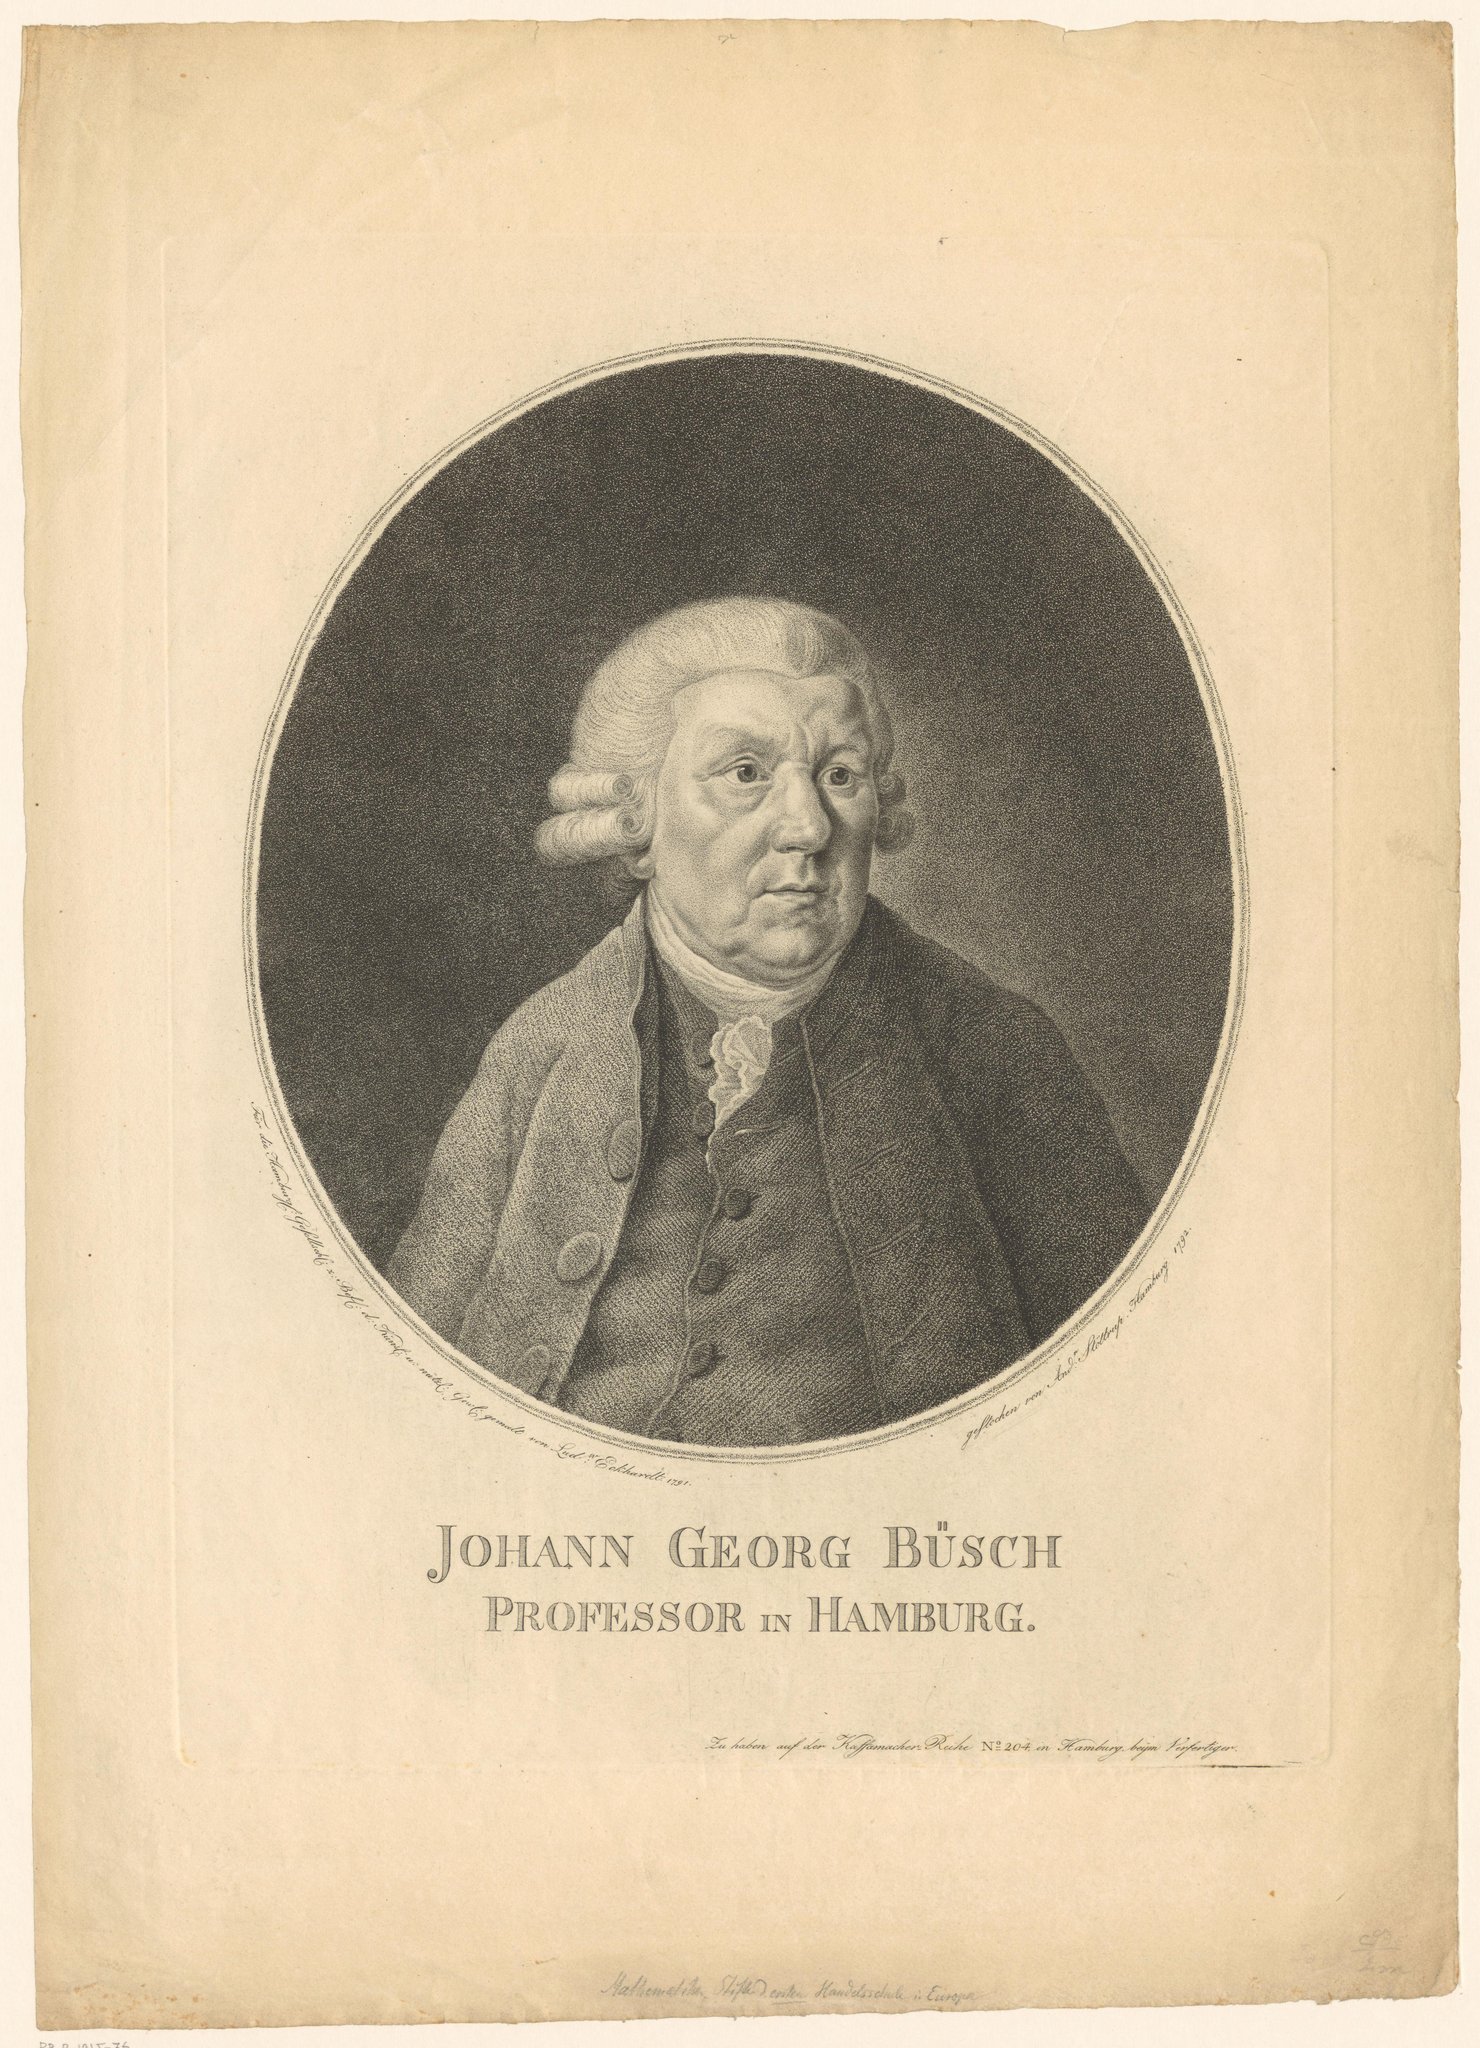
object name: print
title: Portret van Johann Georg Büsch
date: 1792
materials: paper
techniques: printmaking, etching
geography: hamburg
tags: germany, historical persons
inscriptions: collector's mark: Lugt 2228